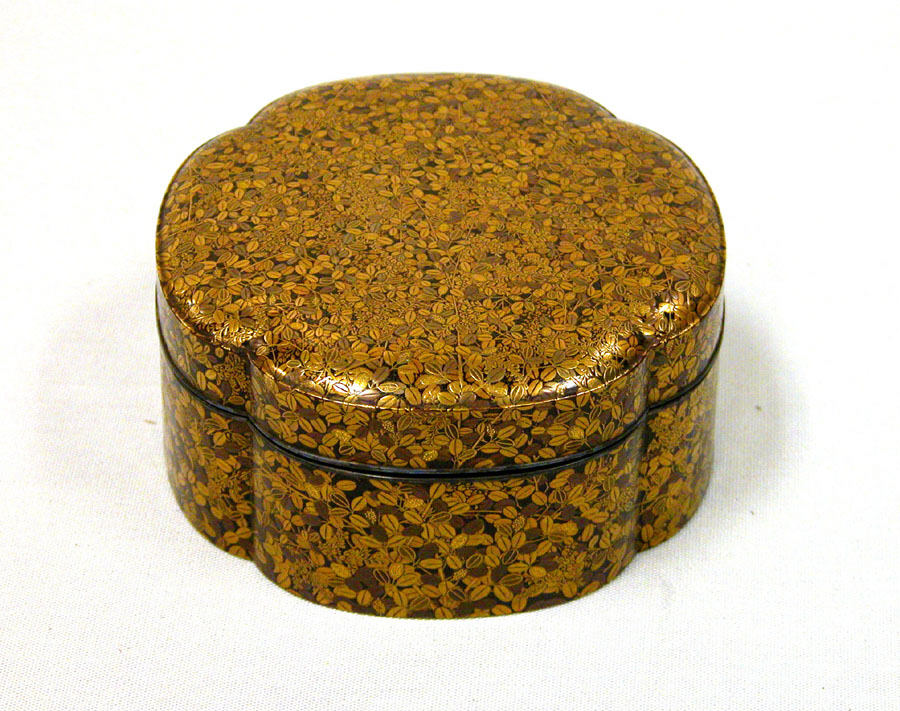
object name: box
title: Box with Bush Clover Design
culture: japanese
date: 1801-1900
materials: gold, lacquer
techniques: maki